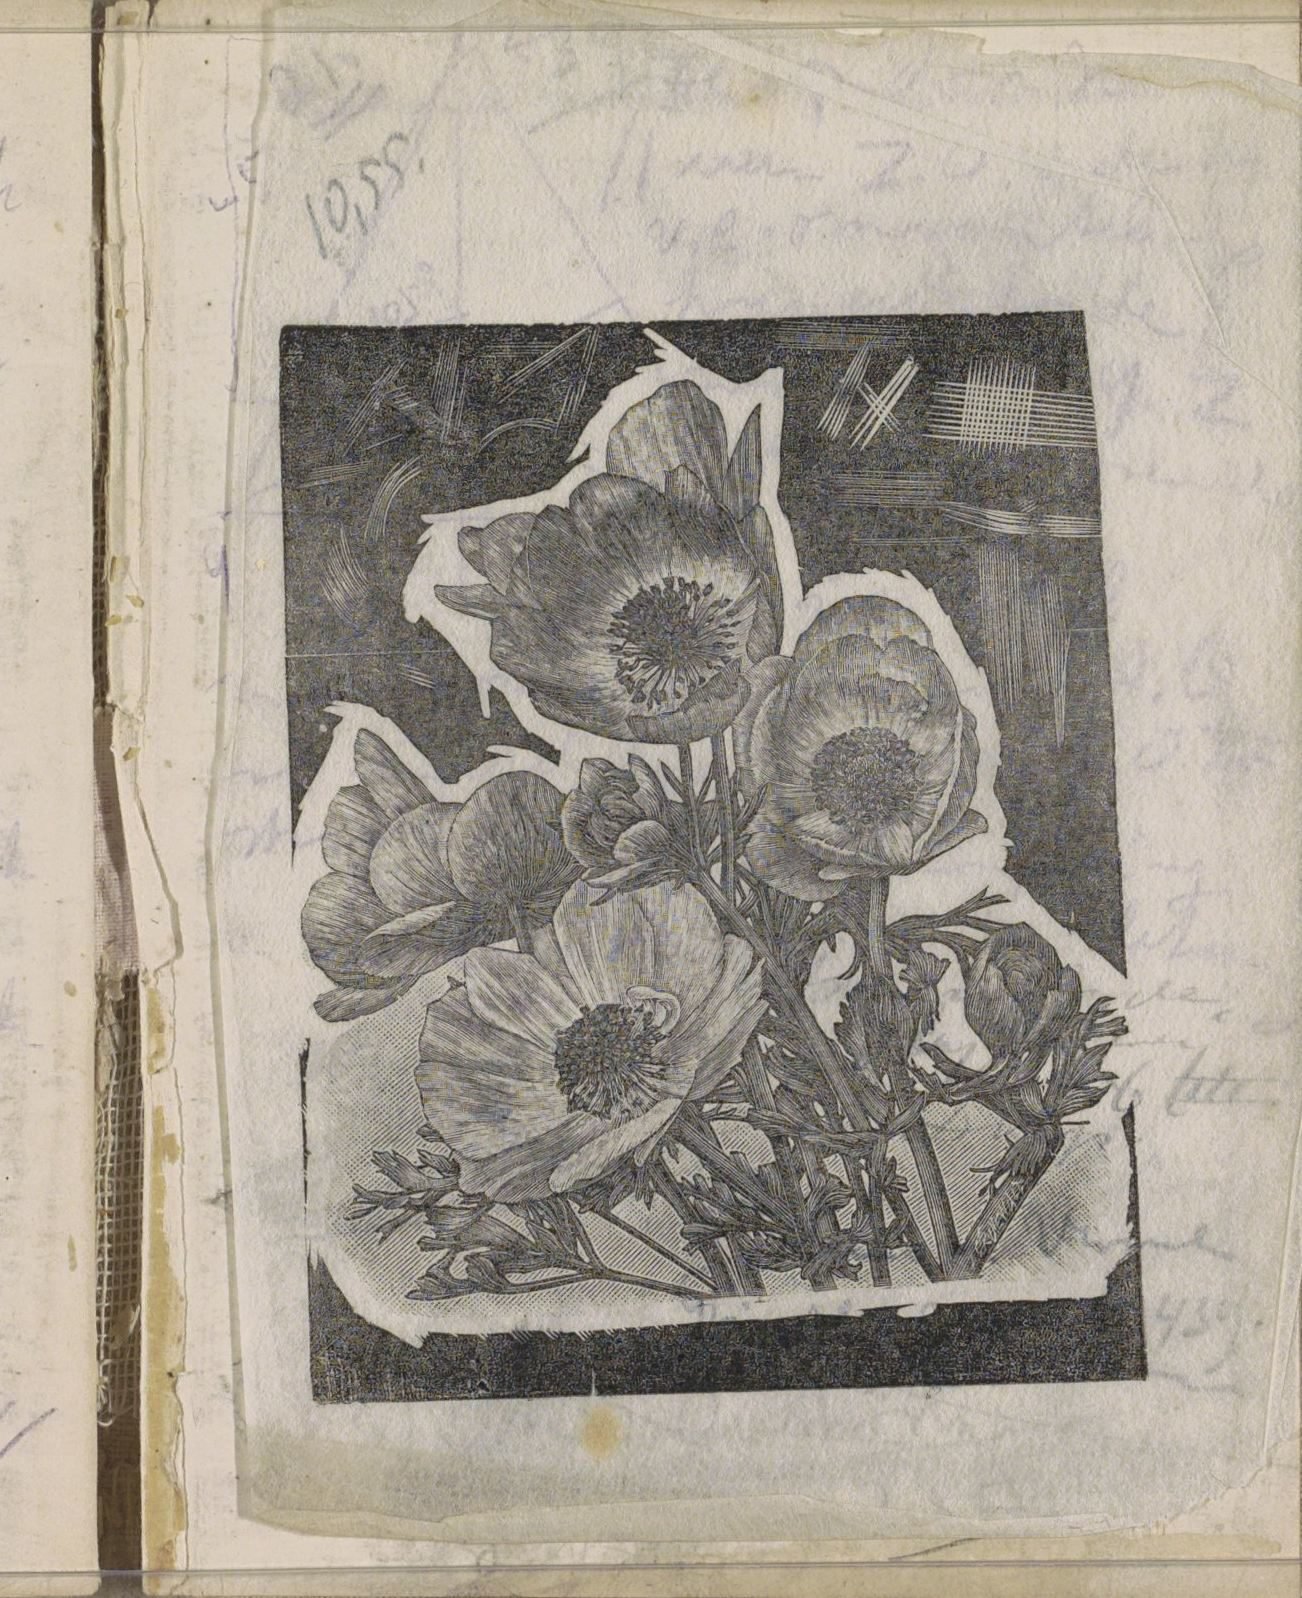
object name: sketchbook leaf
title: Bos anemonen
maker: reijer stolk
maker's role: draughtsman, print maker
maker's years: 1896-1945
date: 1916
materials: paper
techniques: engraving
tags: flowers, flowers: anemone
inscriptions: signature: ‘[...] GRO[...]EWA[...]’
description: Los blad tussen blad 72 en het achterste schutblad uit een schetsboek met 72 bladen.